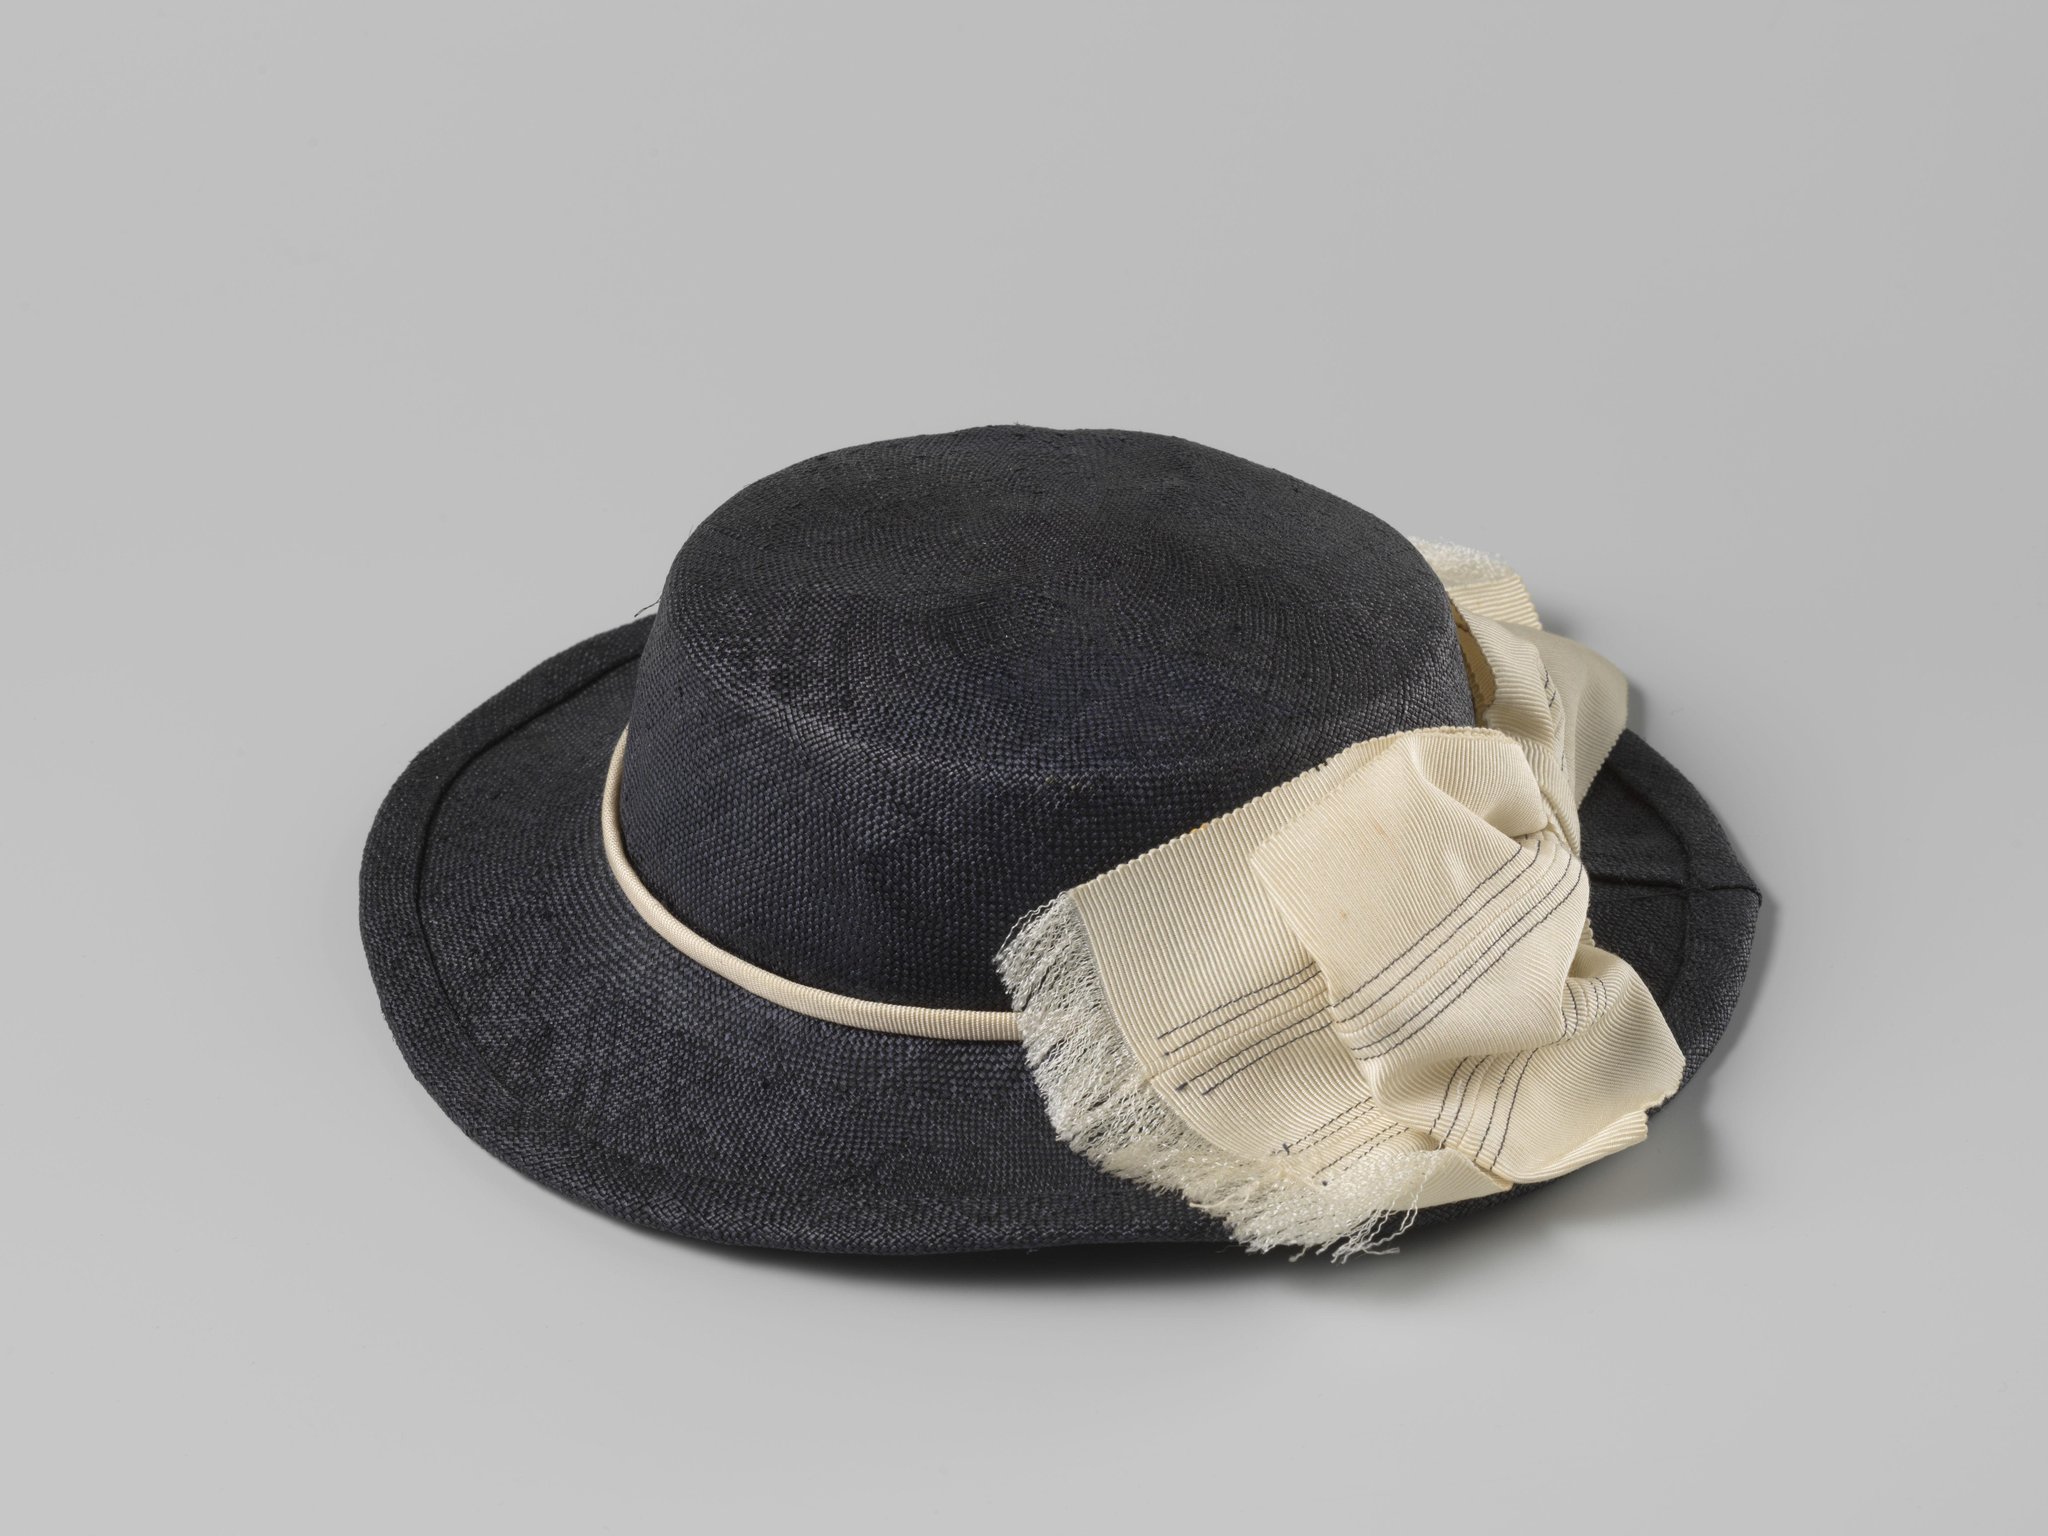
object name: boater, matelot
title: Matelot van blauw stro, versierd met een witte strik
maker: Anonymous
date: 1930-1940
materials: silk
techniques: rib binding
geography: amsterdam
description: Matelot van blauw stro, met witte strik. Ronde bol met enigszins hangende rand. Met een hoedenelastiek. Een smal, bolrond gevuld hoedenlint van witte ripszijde. Midden achter ligt een brede strik met blauwe stiksels half tegen de bol, half op de rand. Met label aan de binnenzijde waarop het adres: De Prijslijst/AMSTERDAM/53 P.C. HOOFTSTRAAT.